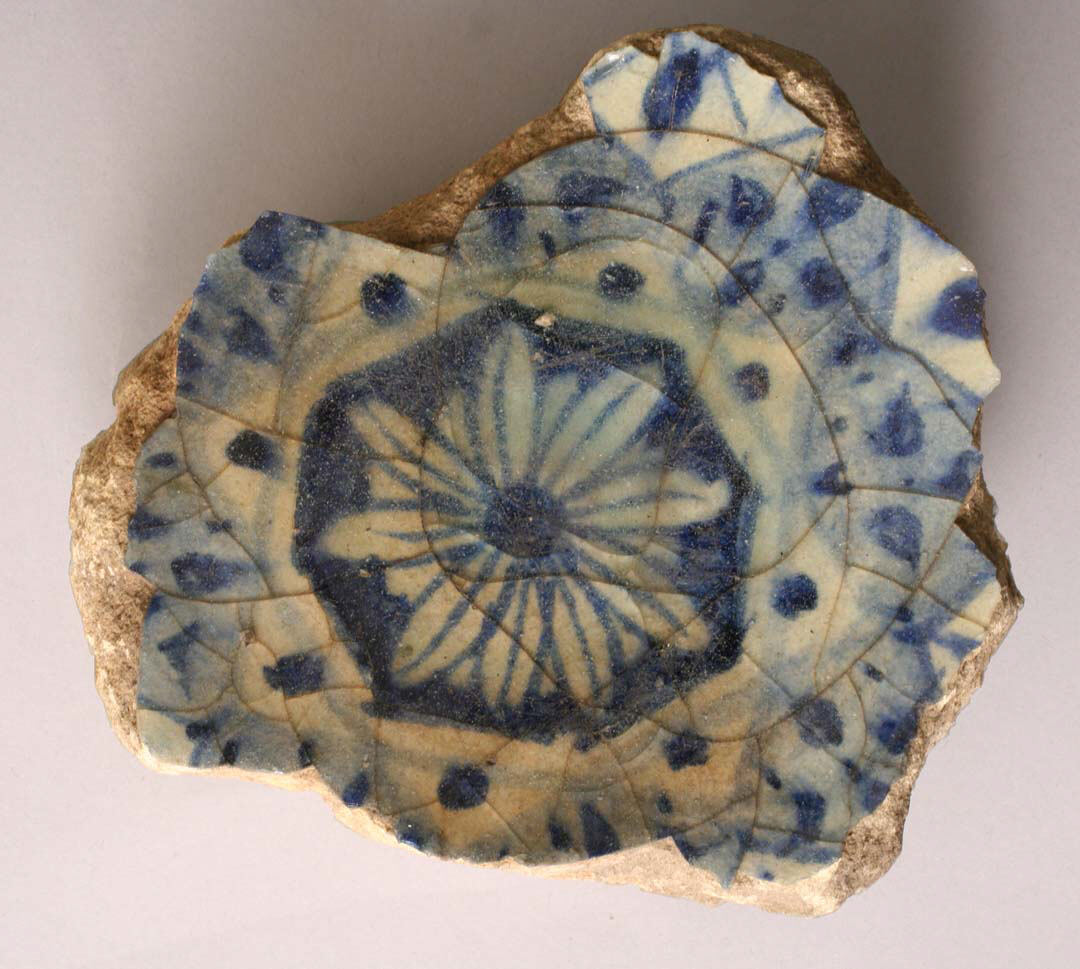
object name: ceramic fragment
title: Fragment of a Bowl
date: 1301-1500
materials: glaze, stonepaste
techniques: painting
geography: egypt or syria